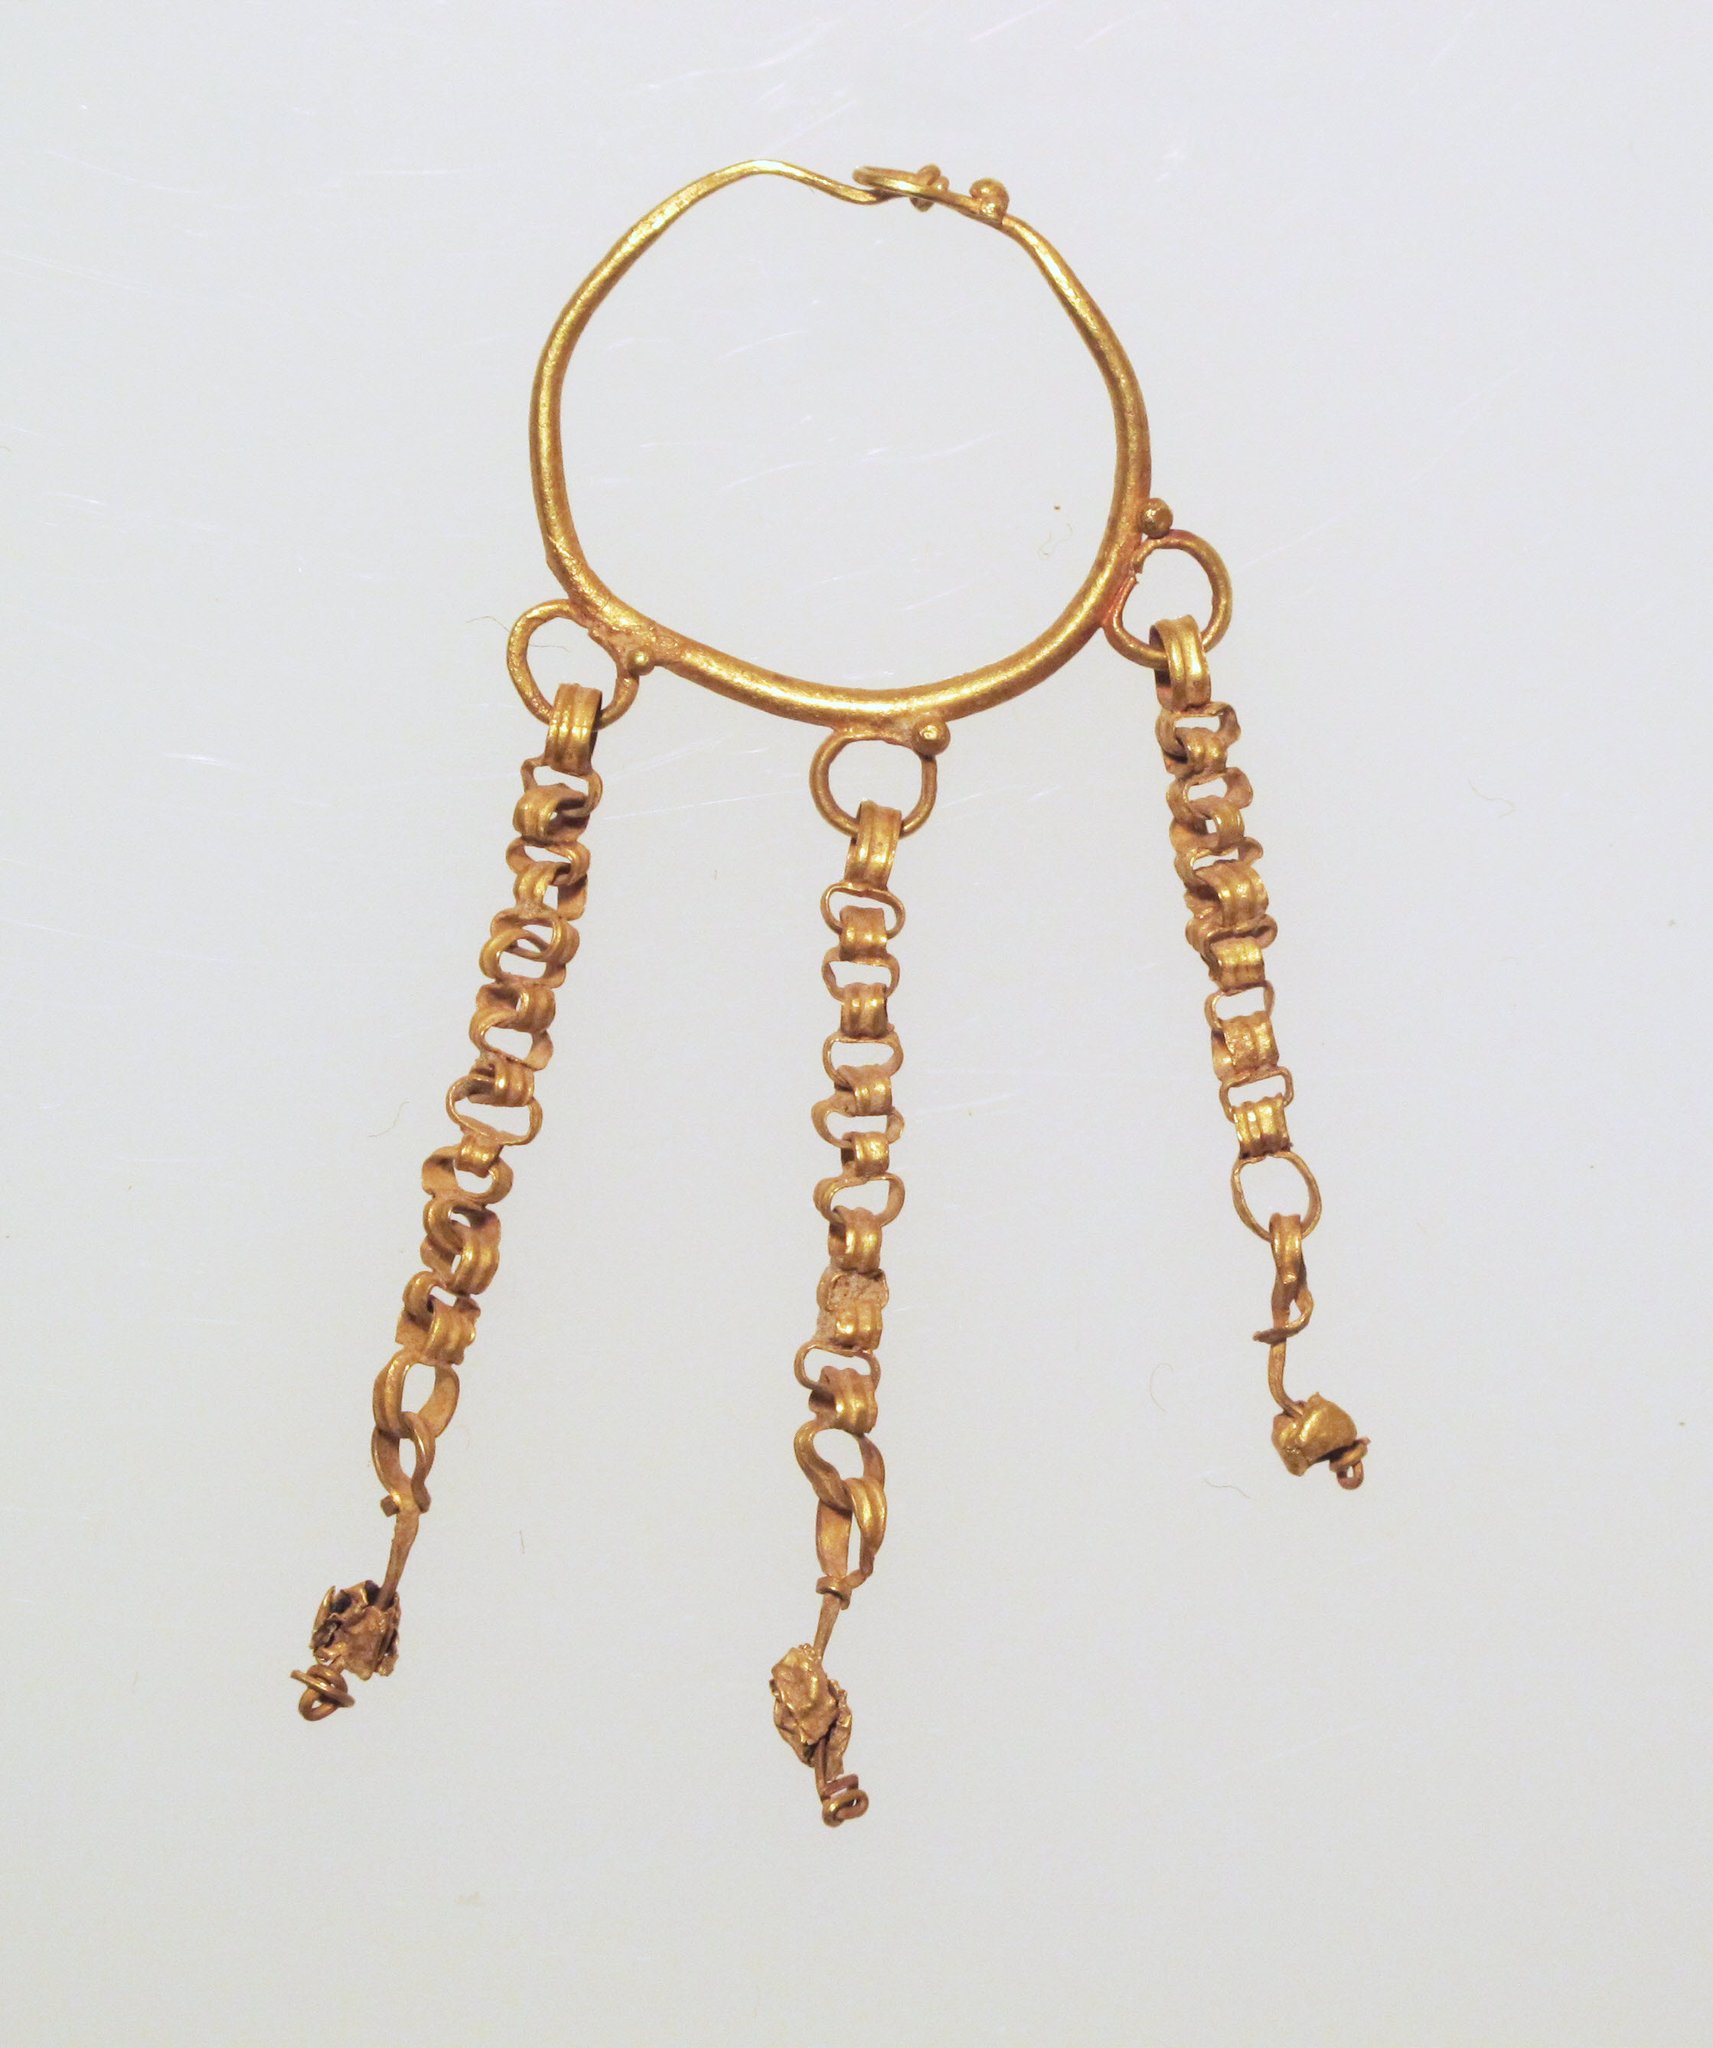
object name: earring with pendant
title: Earring with chain pendants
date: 7000 BCE-330 CE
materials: gold